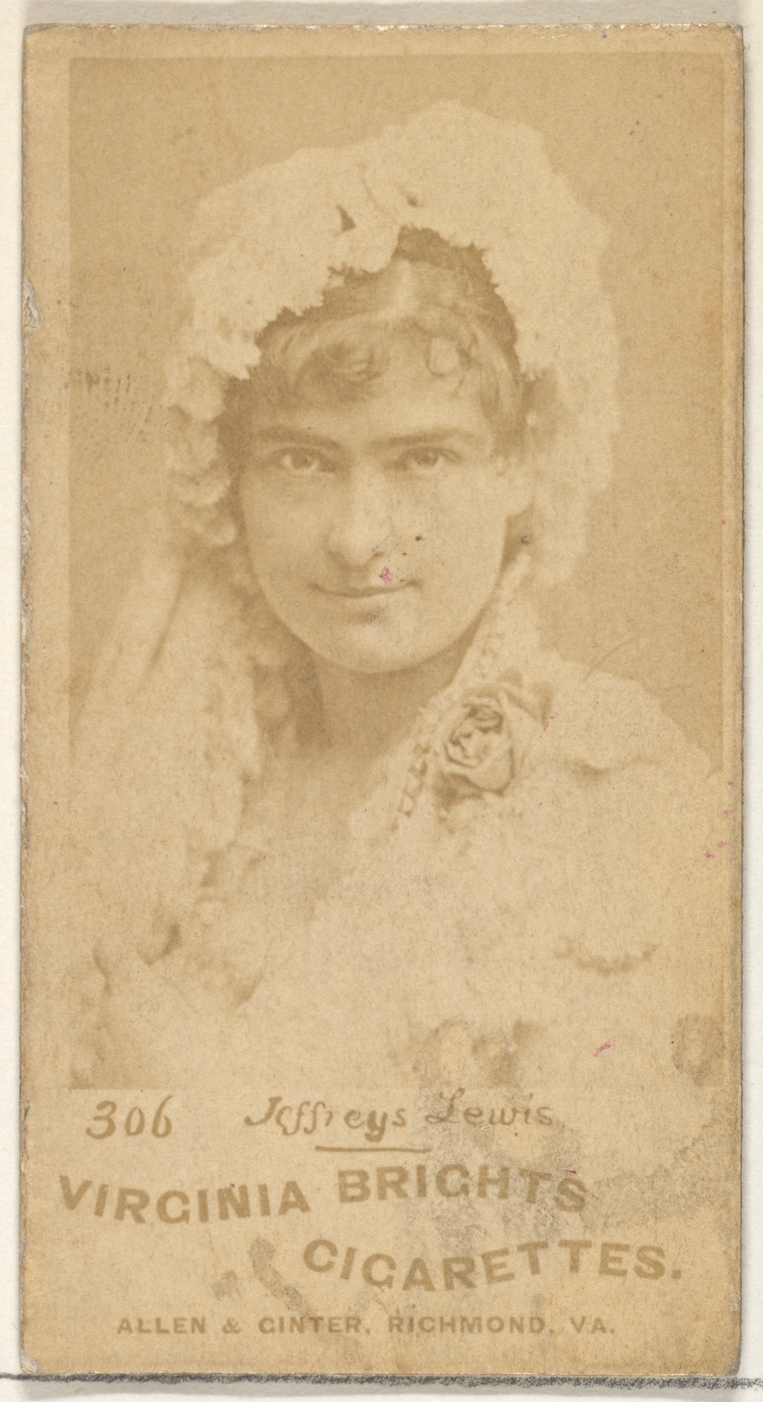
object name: photograph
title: Card 306, Jeffreys Lewis, from the Actors and Actresses series (N45, Type 1) for Virginia Brights Cigarettes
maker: allen & ginter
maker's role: publisher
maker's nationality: american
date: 1888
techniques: albumen silver print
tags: portraits,women,actresses